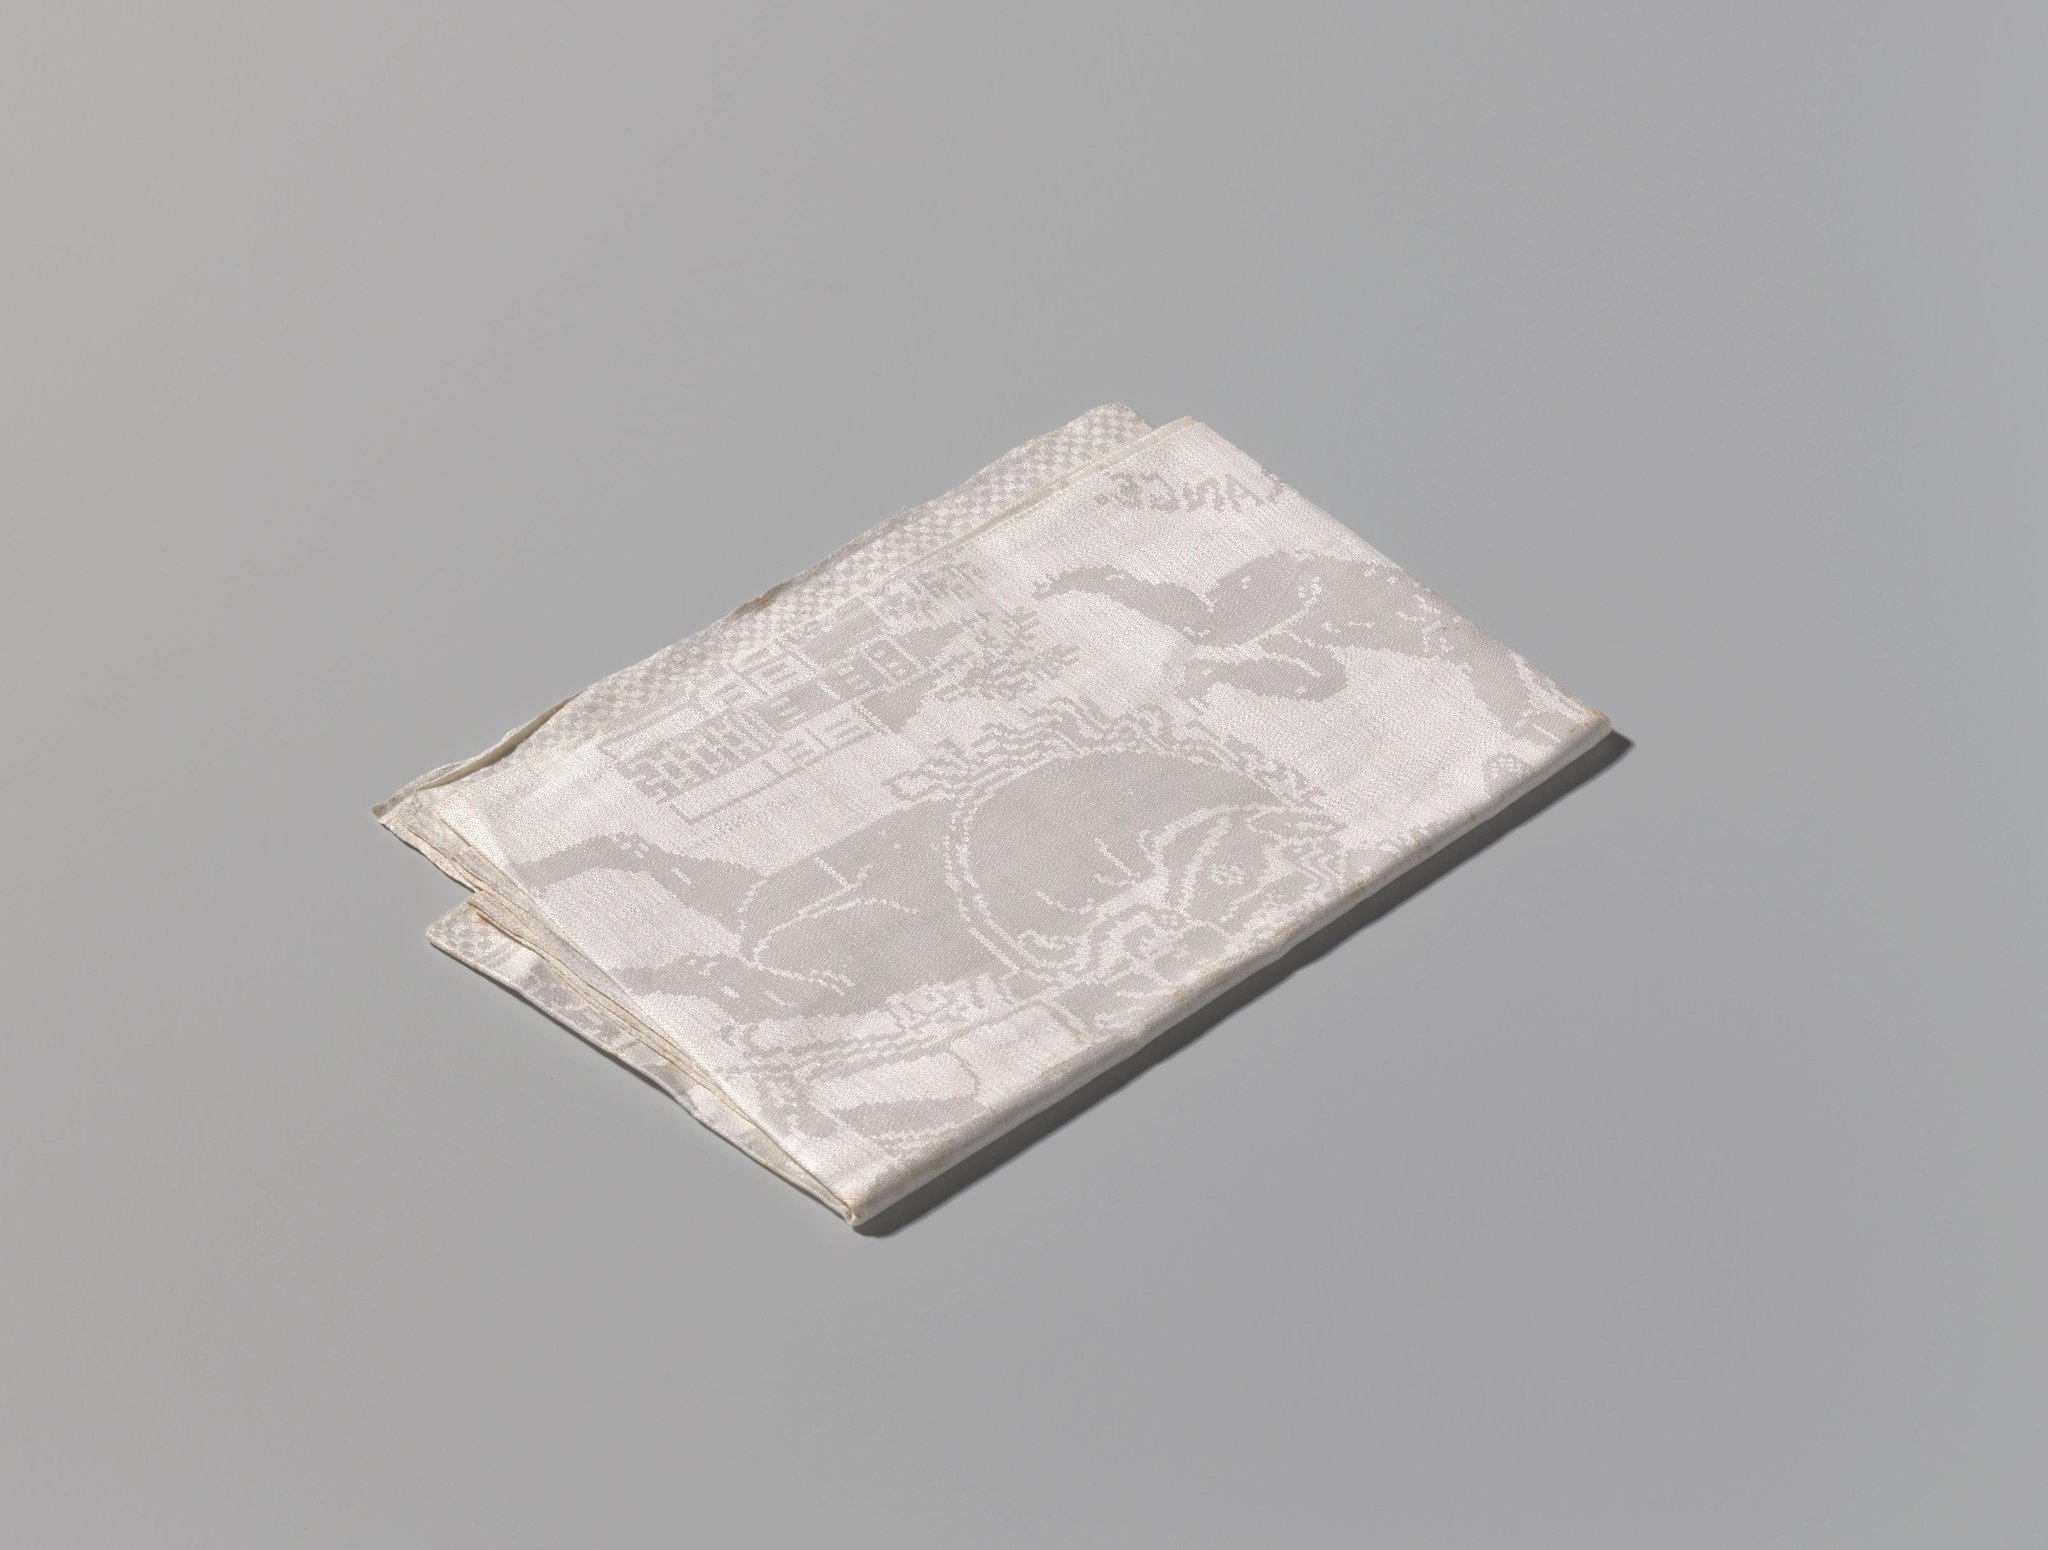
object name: napkin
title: Servet op de verovering van Grave door stadhouder Willem III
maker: Anonymous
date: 1674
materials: linen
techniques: damask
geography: brabant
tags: the hague, william iii (prince of orange and king of england, scotland, and ireland), grave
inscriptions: mark: ‘AG’, mark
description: Servet van linnendamast met de verovering van Grave door stadhouder Willem III. Middenveld: Het symmetrisch patroon vertoont van onder naar boven de volgende taferelen: 1 Stadsgezicht met het opschrift D'GRAEF en het onderschrift: DE BORCHERS VAN GRAEF DANCKEN SYN HOOCHEYT VAN HVN VERLOSSINGHE. 2 Staande mannelijke figuur naar rechts gekeerd, voor hem een geknielde man naar links gewend met een dienaar achter zich. 3 Ruiter te paard bij een kasteel. 4 Wapen van Engeland met de leus LANG LEEFT ONSEN VICTORIUESE PRINCE VAN ORANGE; daaronder een engel met een bazuin. Ingeweven het jaartal 1674. Staande en liggende randen: Bloem- en vruchtranken.